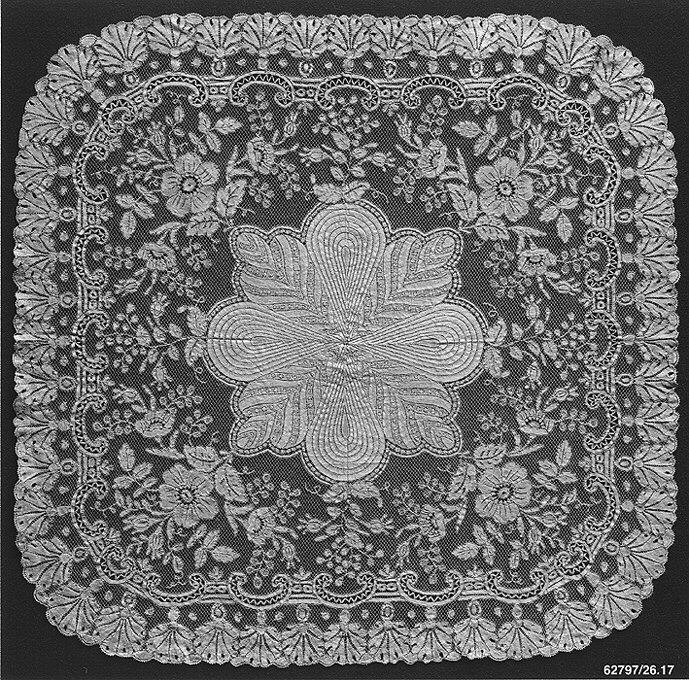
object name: handkerchief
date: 1834-1866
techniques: lace